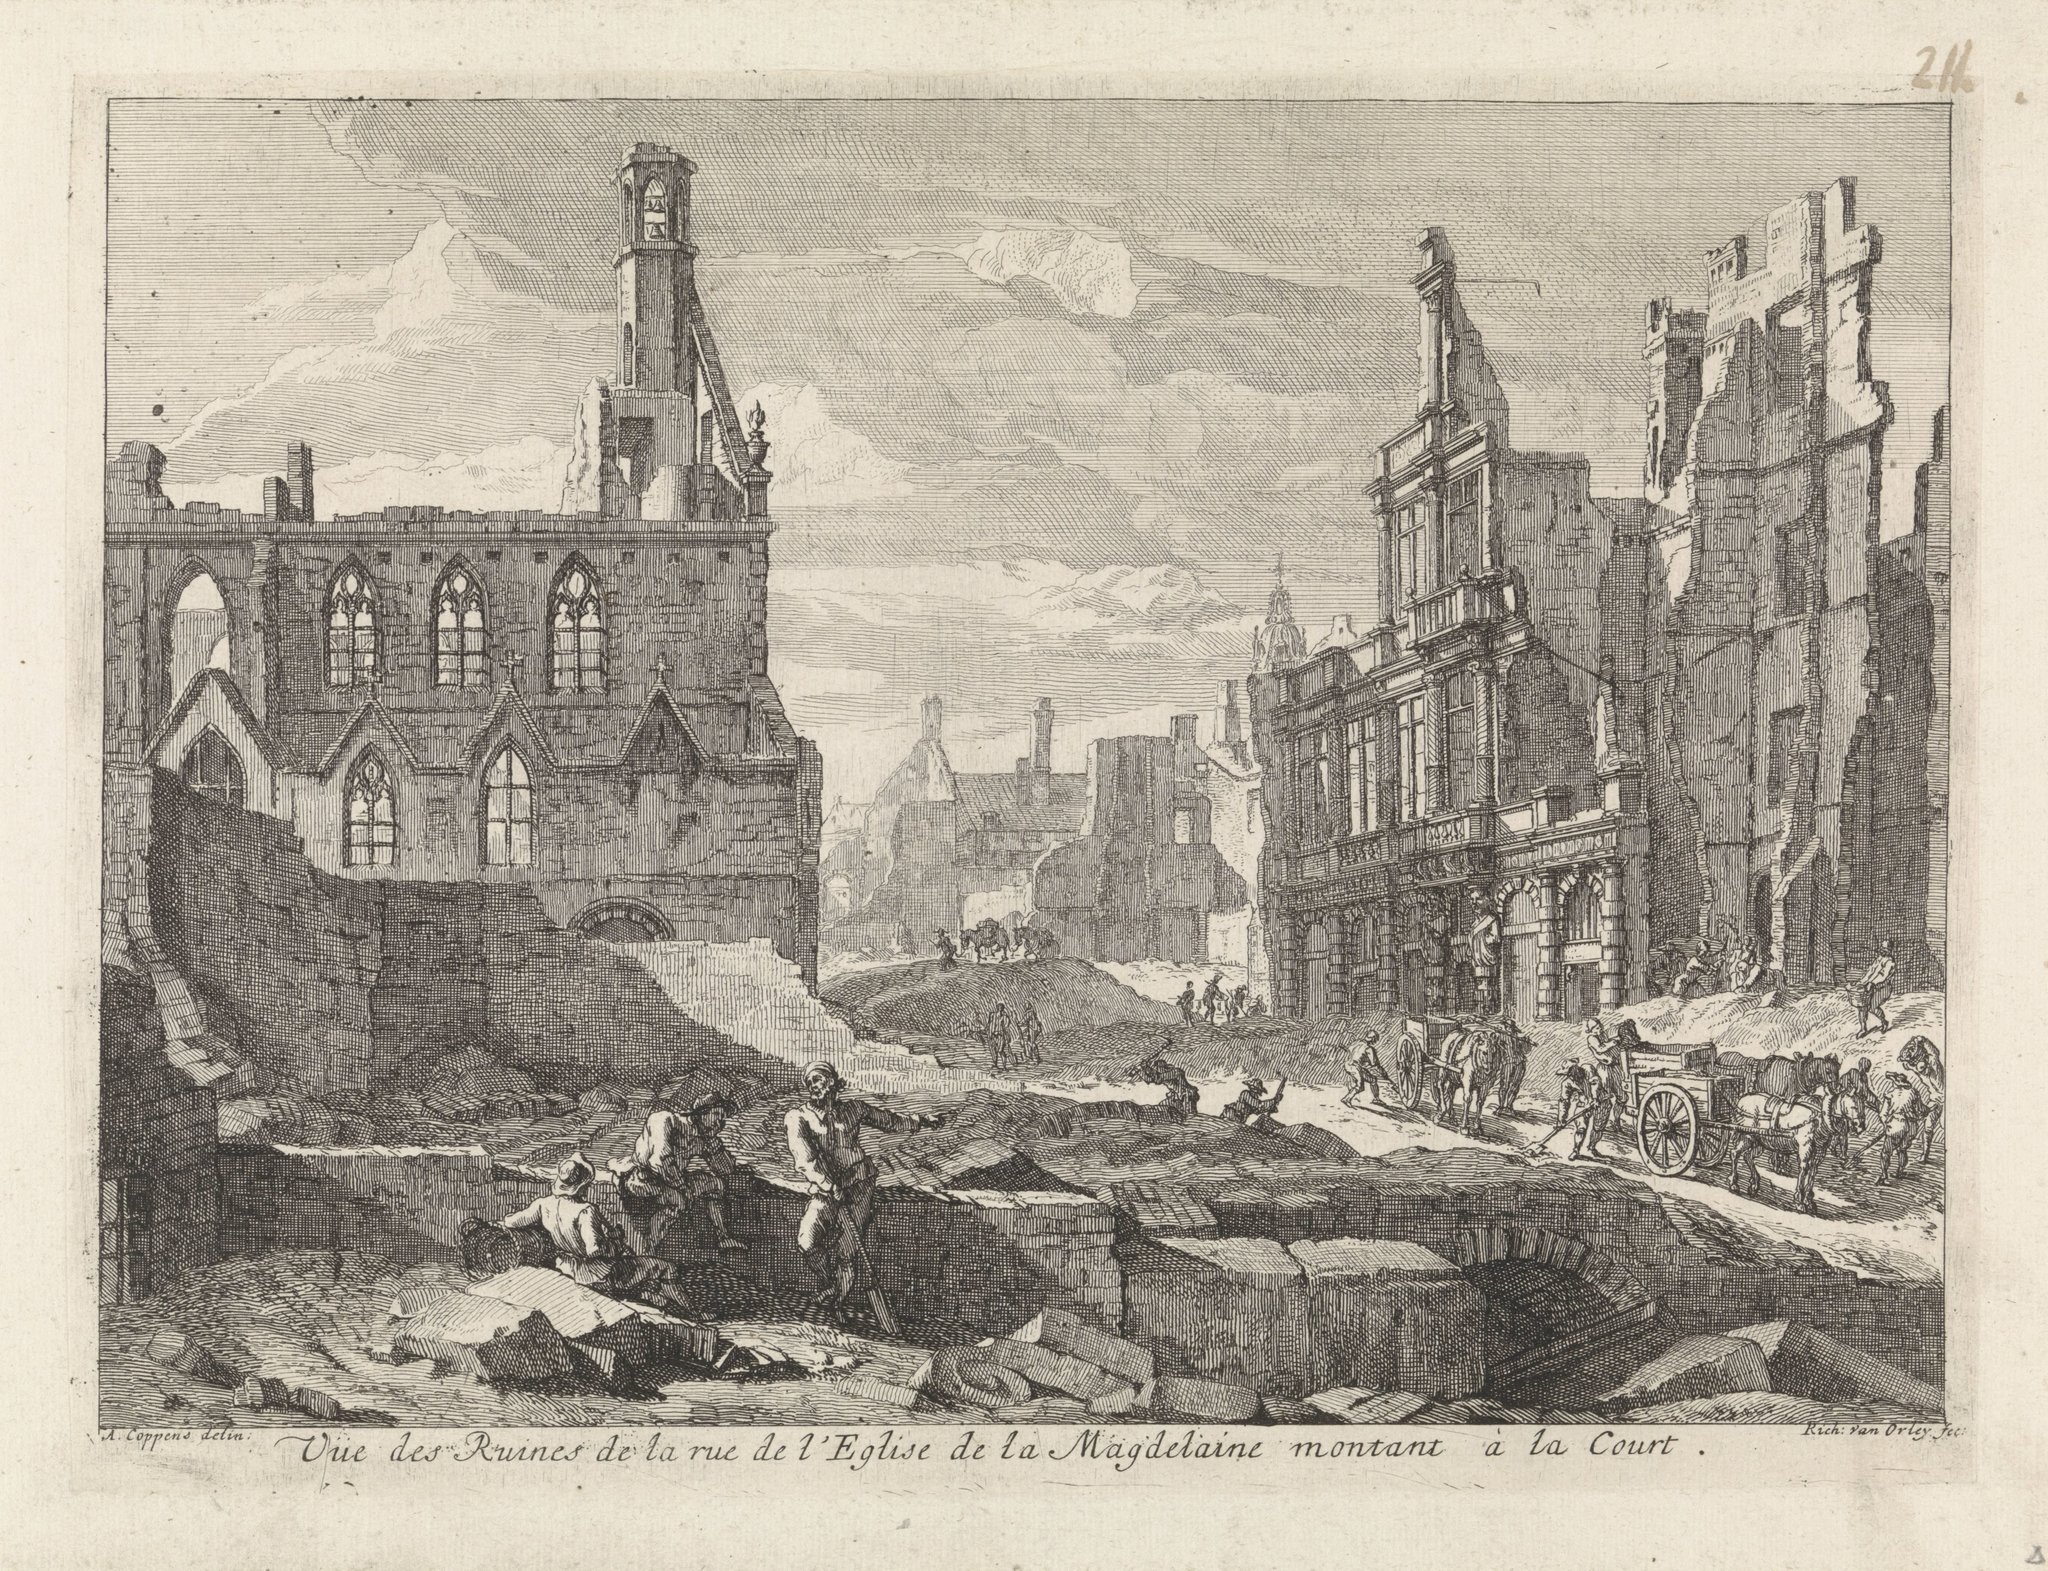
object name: print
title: Vue des Ruines de la rue de l'Eglise de la Magdelaine montant à la Court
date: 1695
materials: paper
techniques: etching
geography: southern netherlands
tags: devastated, ruined place or city (~ warfare), brussels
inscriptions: collector's mark: Lugt 2228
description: Voorstelling van de ruïnes in de Magdalenasteenweg te Brussel na het bombardement door de Fransen, 13-15 augustus 1695. Twaalfde prent in de reeks van twaalf.